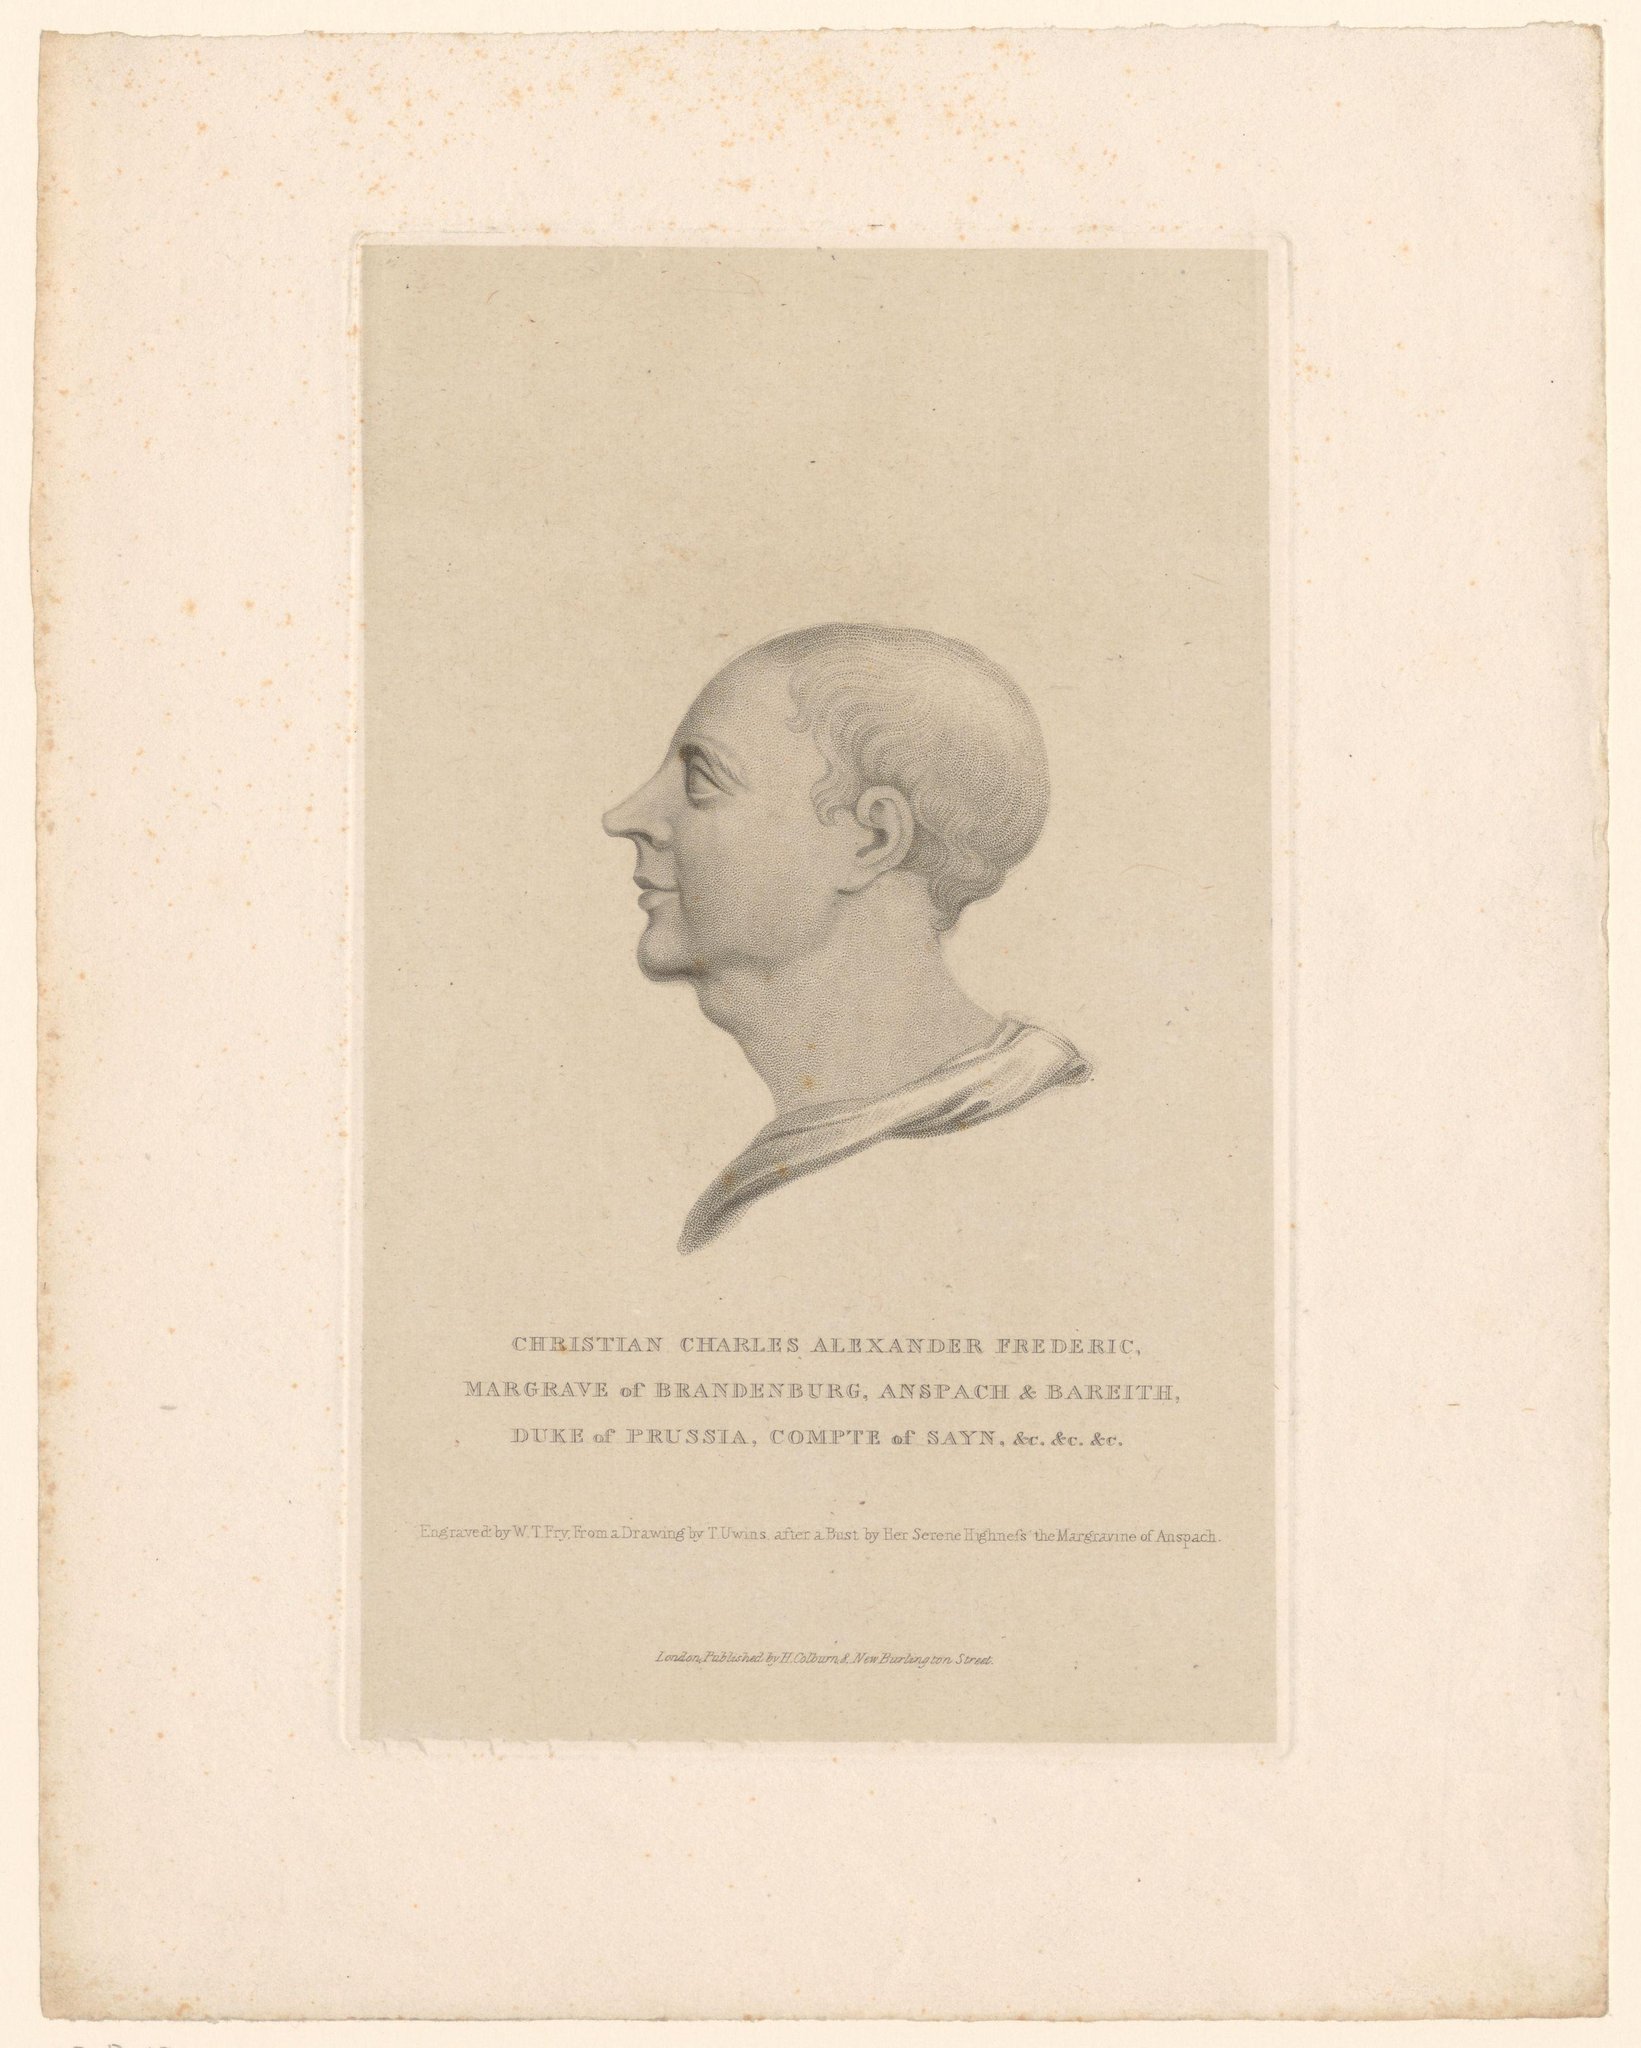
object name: print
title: Portret van Karel Alexander van Brandenburg-Ansbach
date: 1824-1832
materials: paper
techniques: stippling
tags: politician, karel alexander van brandenburg-ansbach, historical persons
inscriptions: collector's mark: Lugt 2228